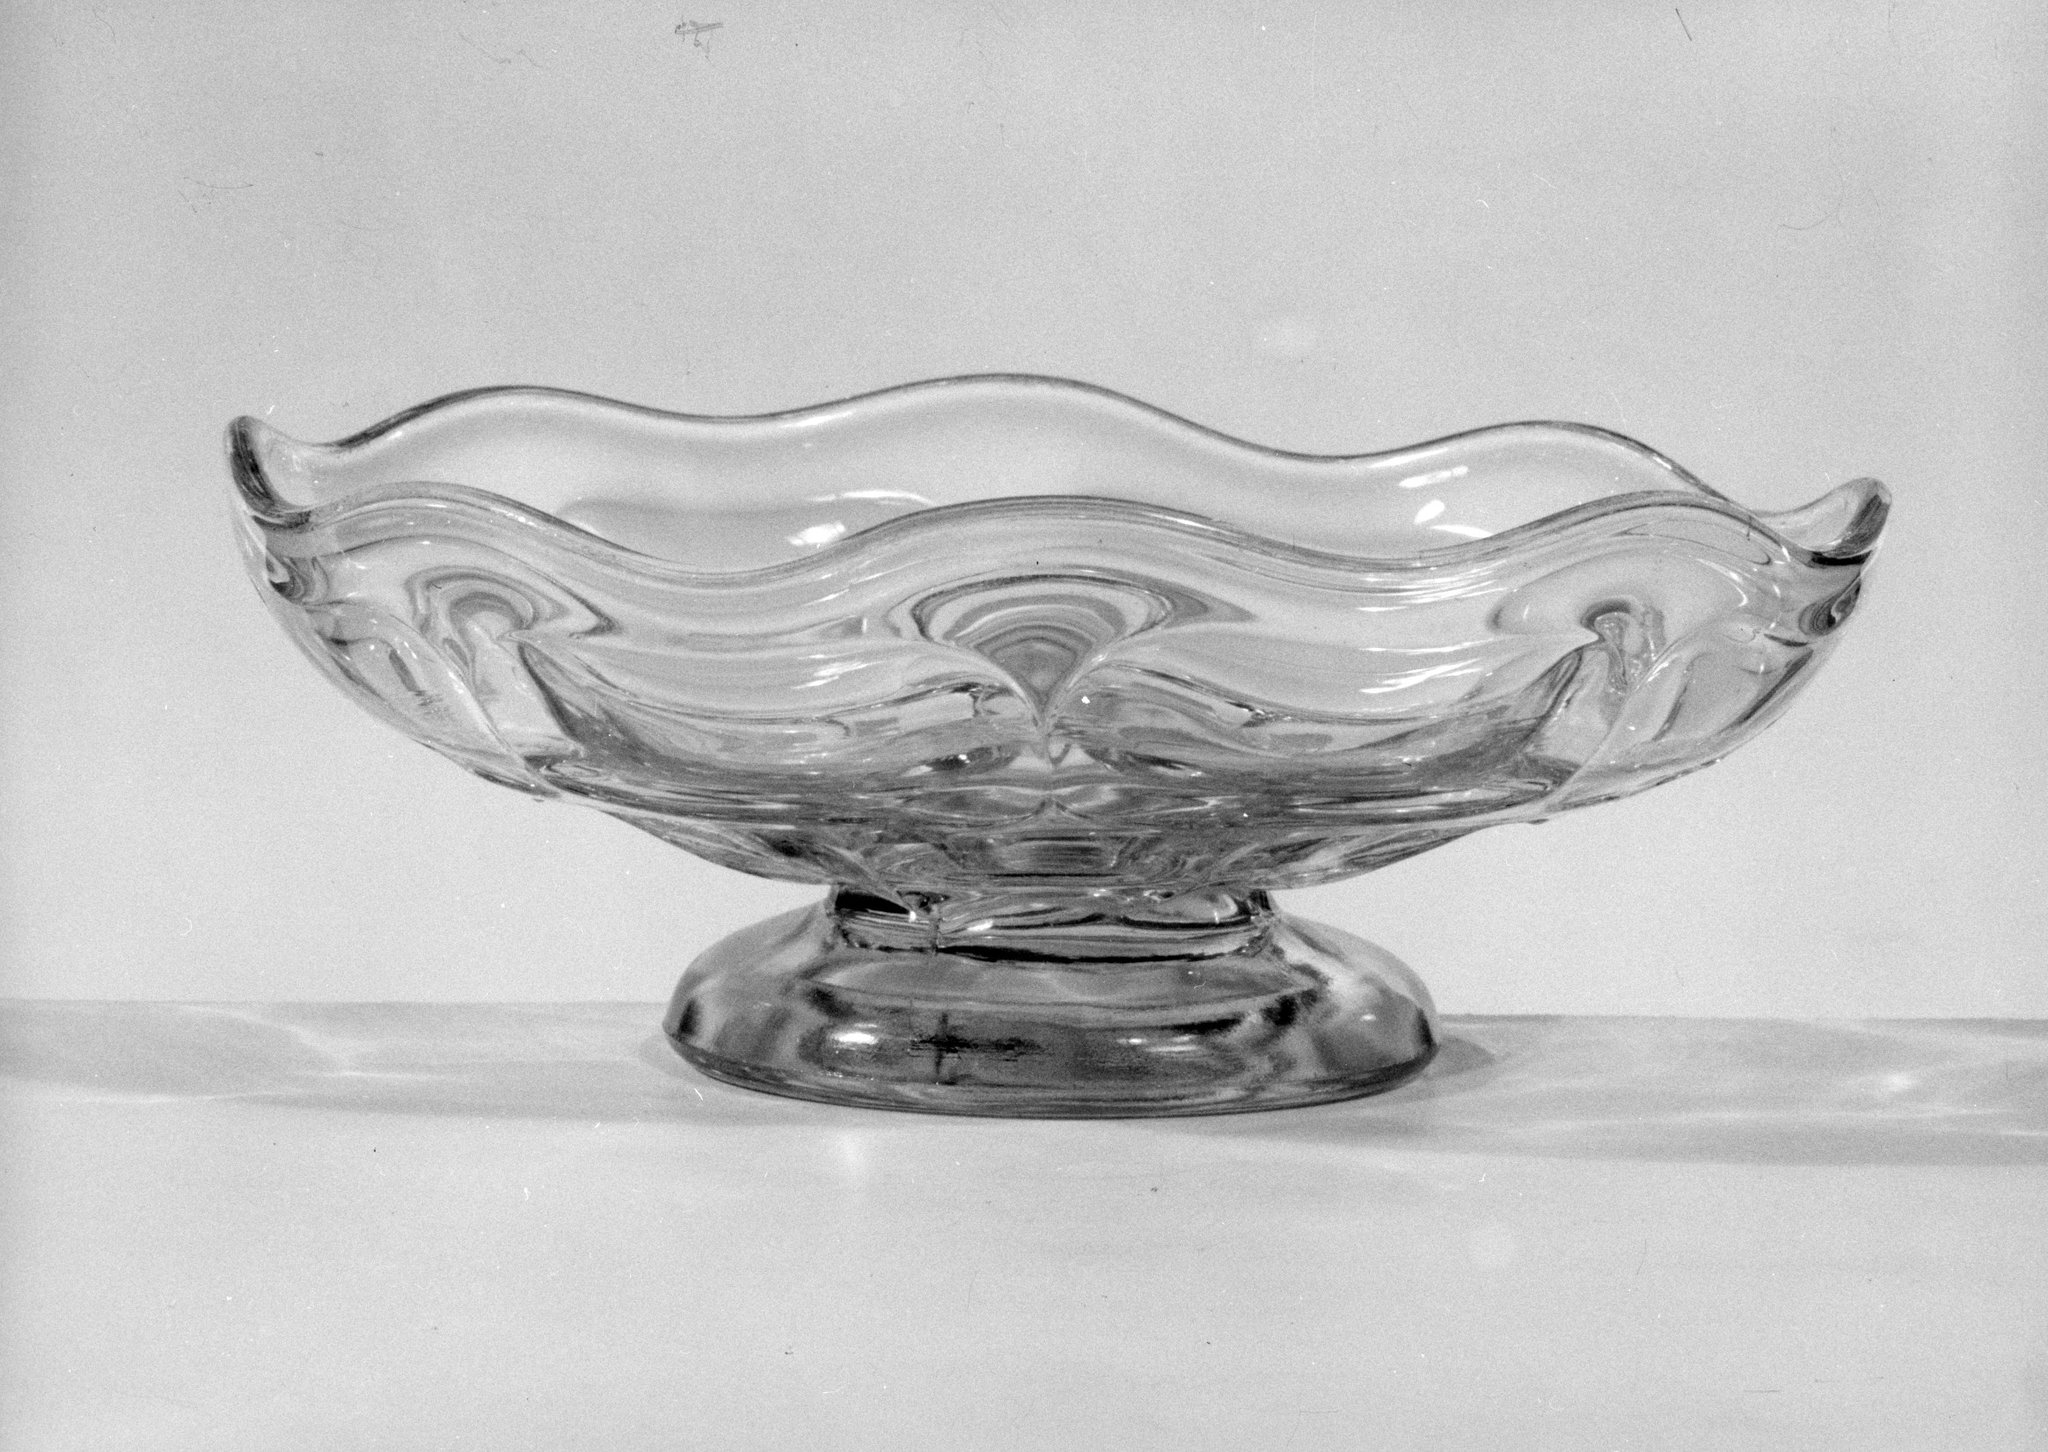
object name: bowl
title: Footed Bowl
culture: american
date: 1830-1870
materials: glass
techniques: pressed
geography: united states